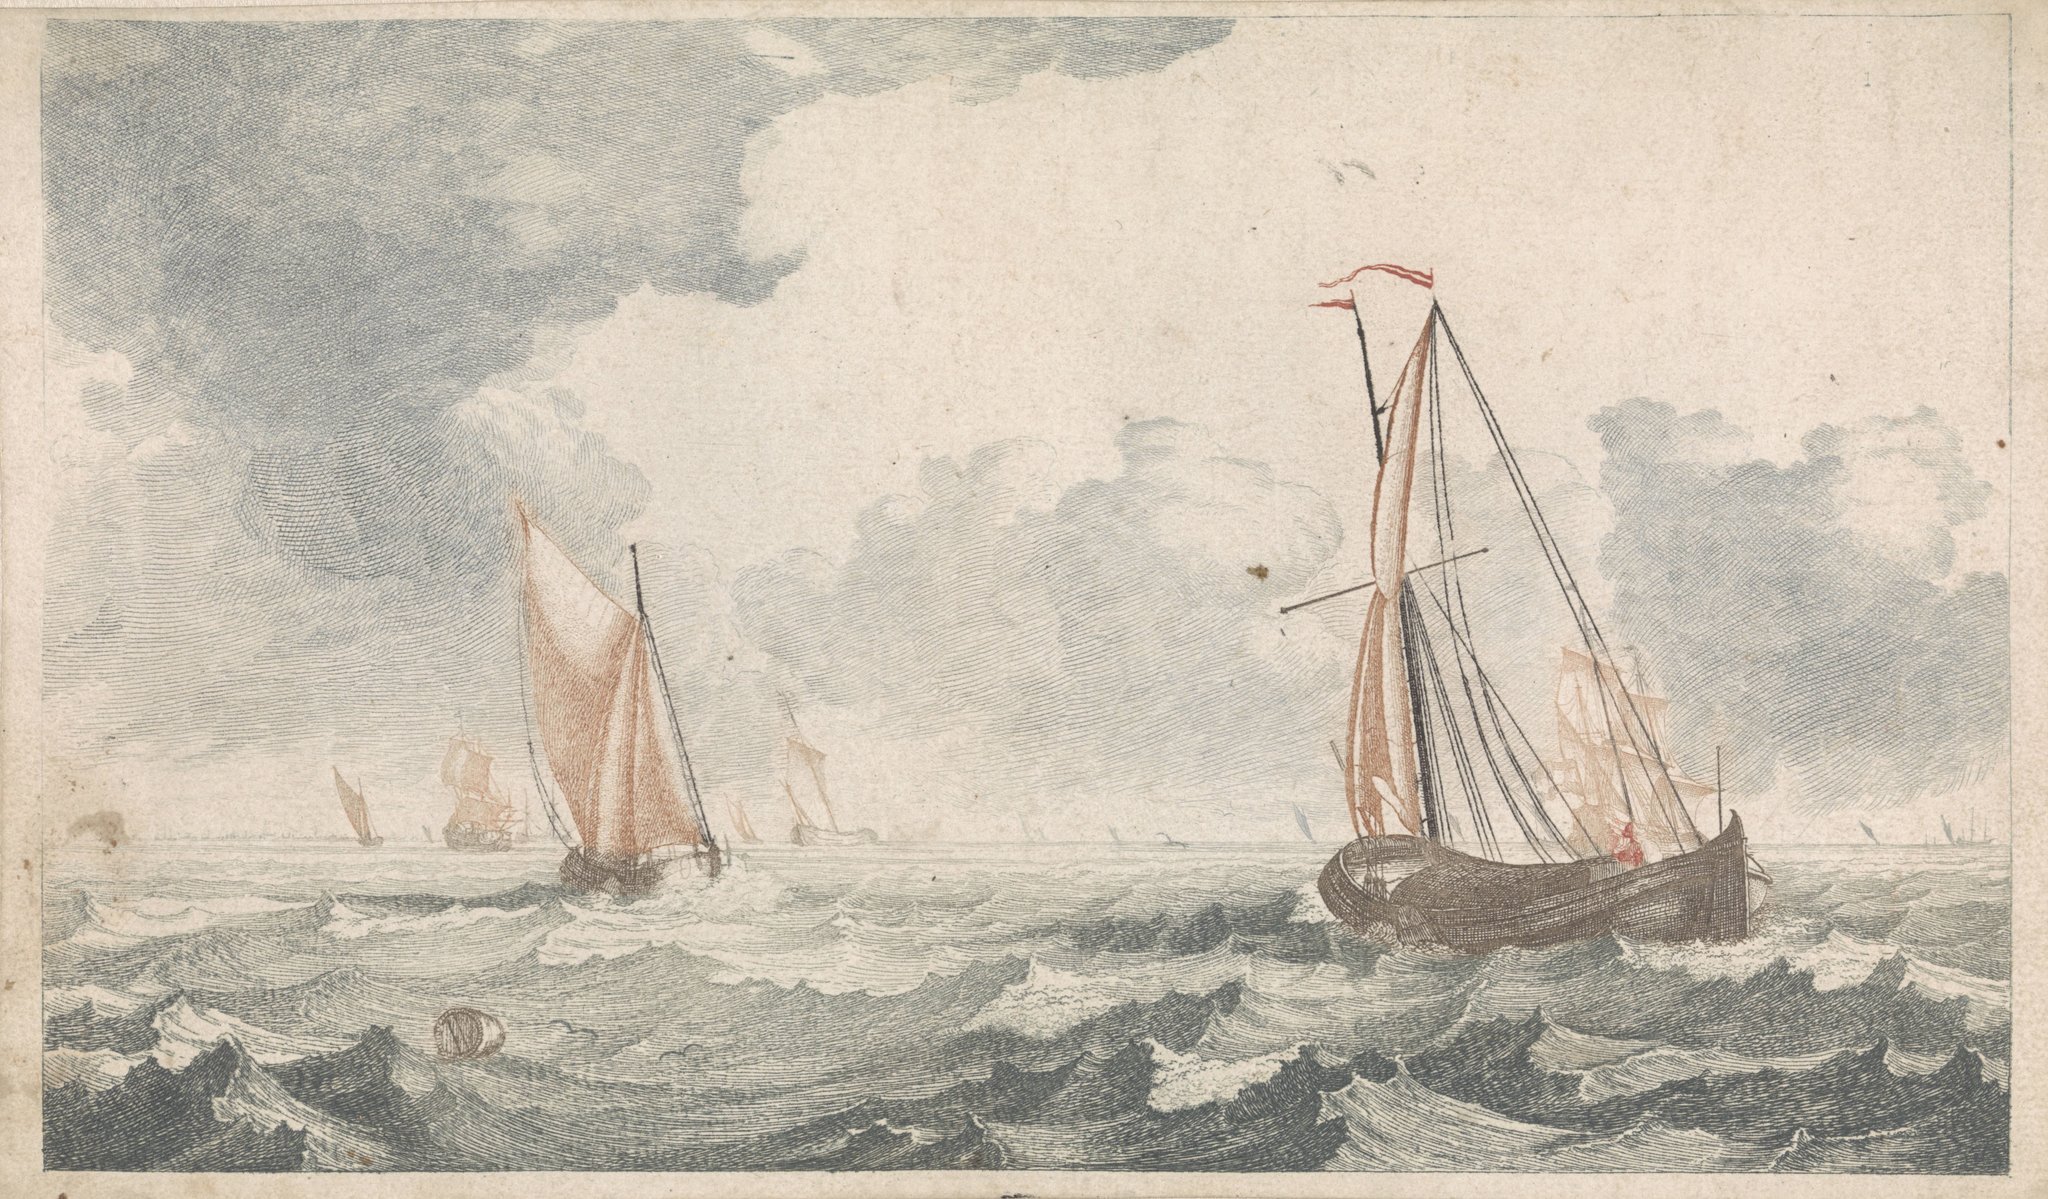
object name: print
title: Twee elkaar tegemoet zeilende platbodems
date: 1688-1698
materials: paper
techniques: etching, lithography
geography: netherlands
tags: sailing-ship, sailing-boat, sea (seascape)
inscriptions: collector's mark: Lugt 2228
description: Twee elkaar tegemoet zeilende platbodems. Links op de voorgrond drijft een ton. Aan de horizon verschillende zeilschepen.